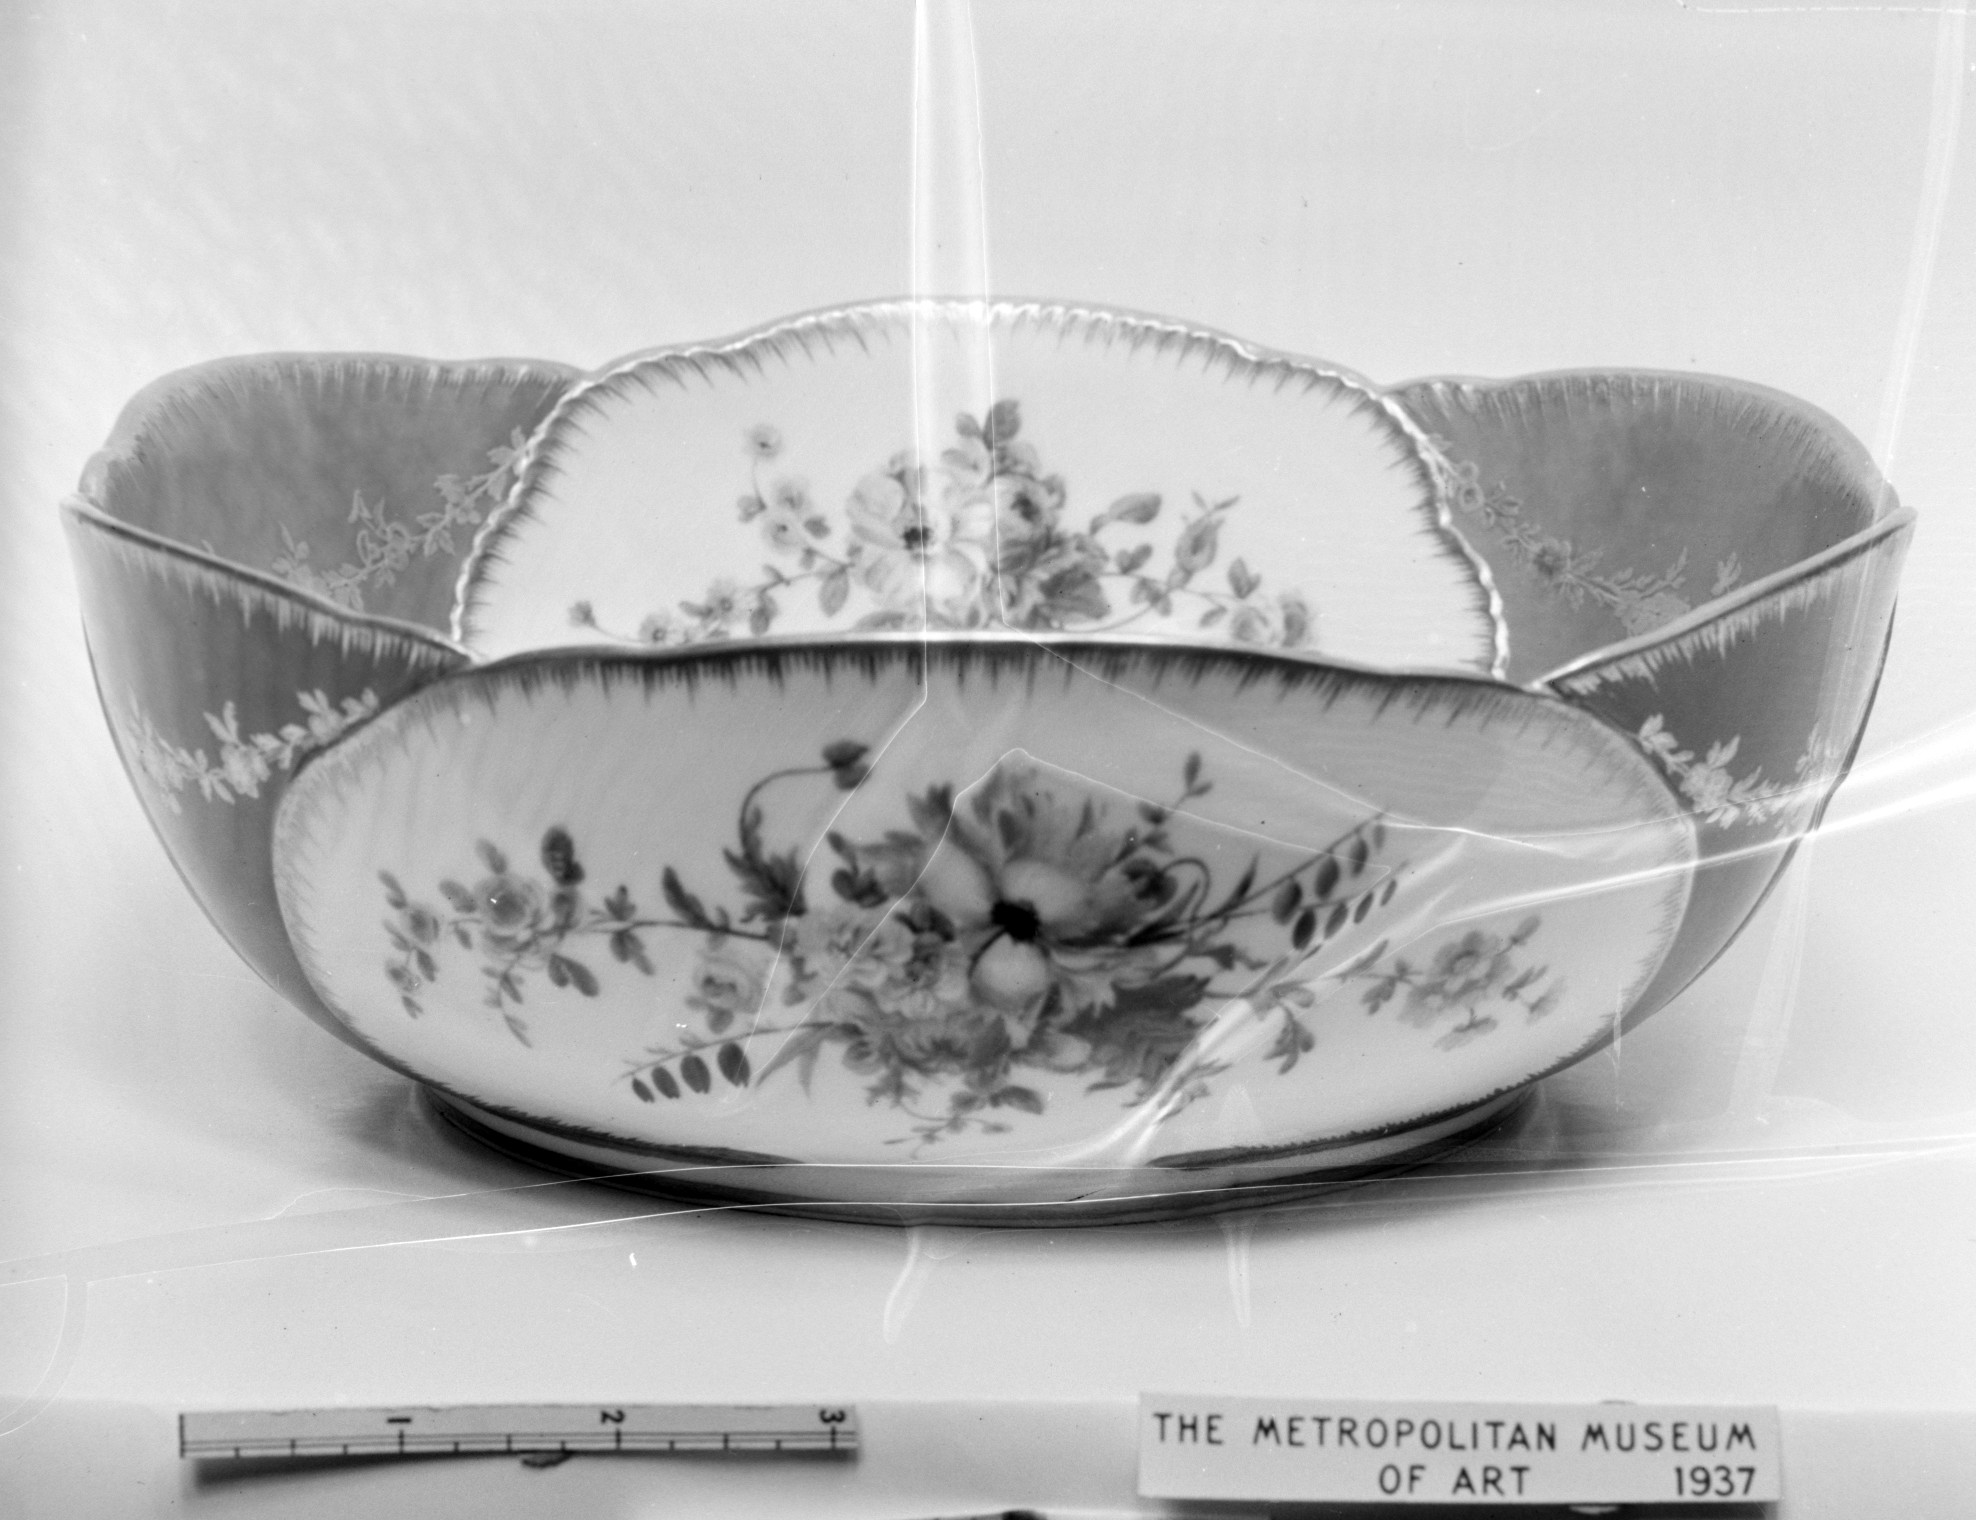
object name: salad bowl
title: Salad bowl (Saladier) (one of six) (part of a service)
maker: sèvres manufactory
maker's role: manufactory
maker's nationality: french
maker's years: 1740-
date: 1771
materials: soft paste porcelain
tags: flowers